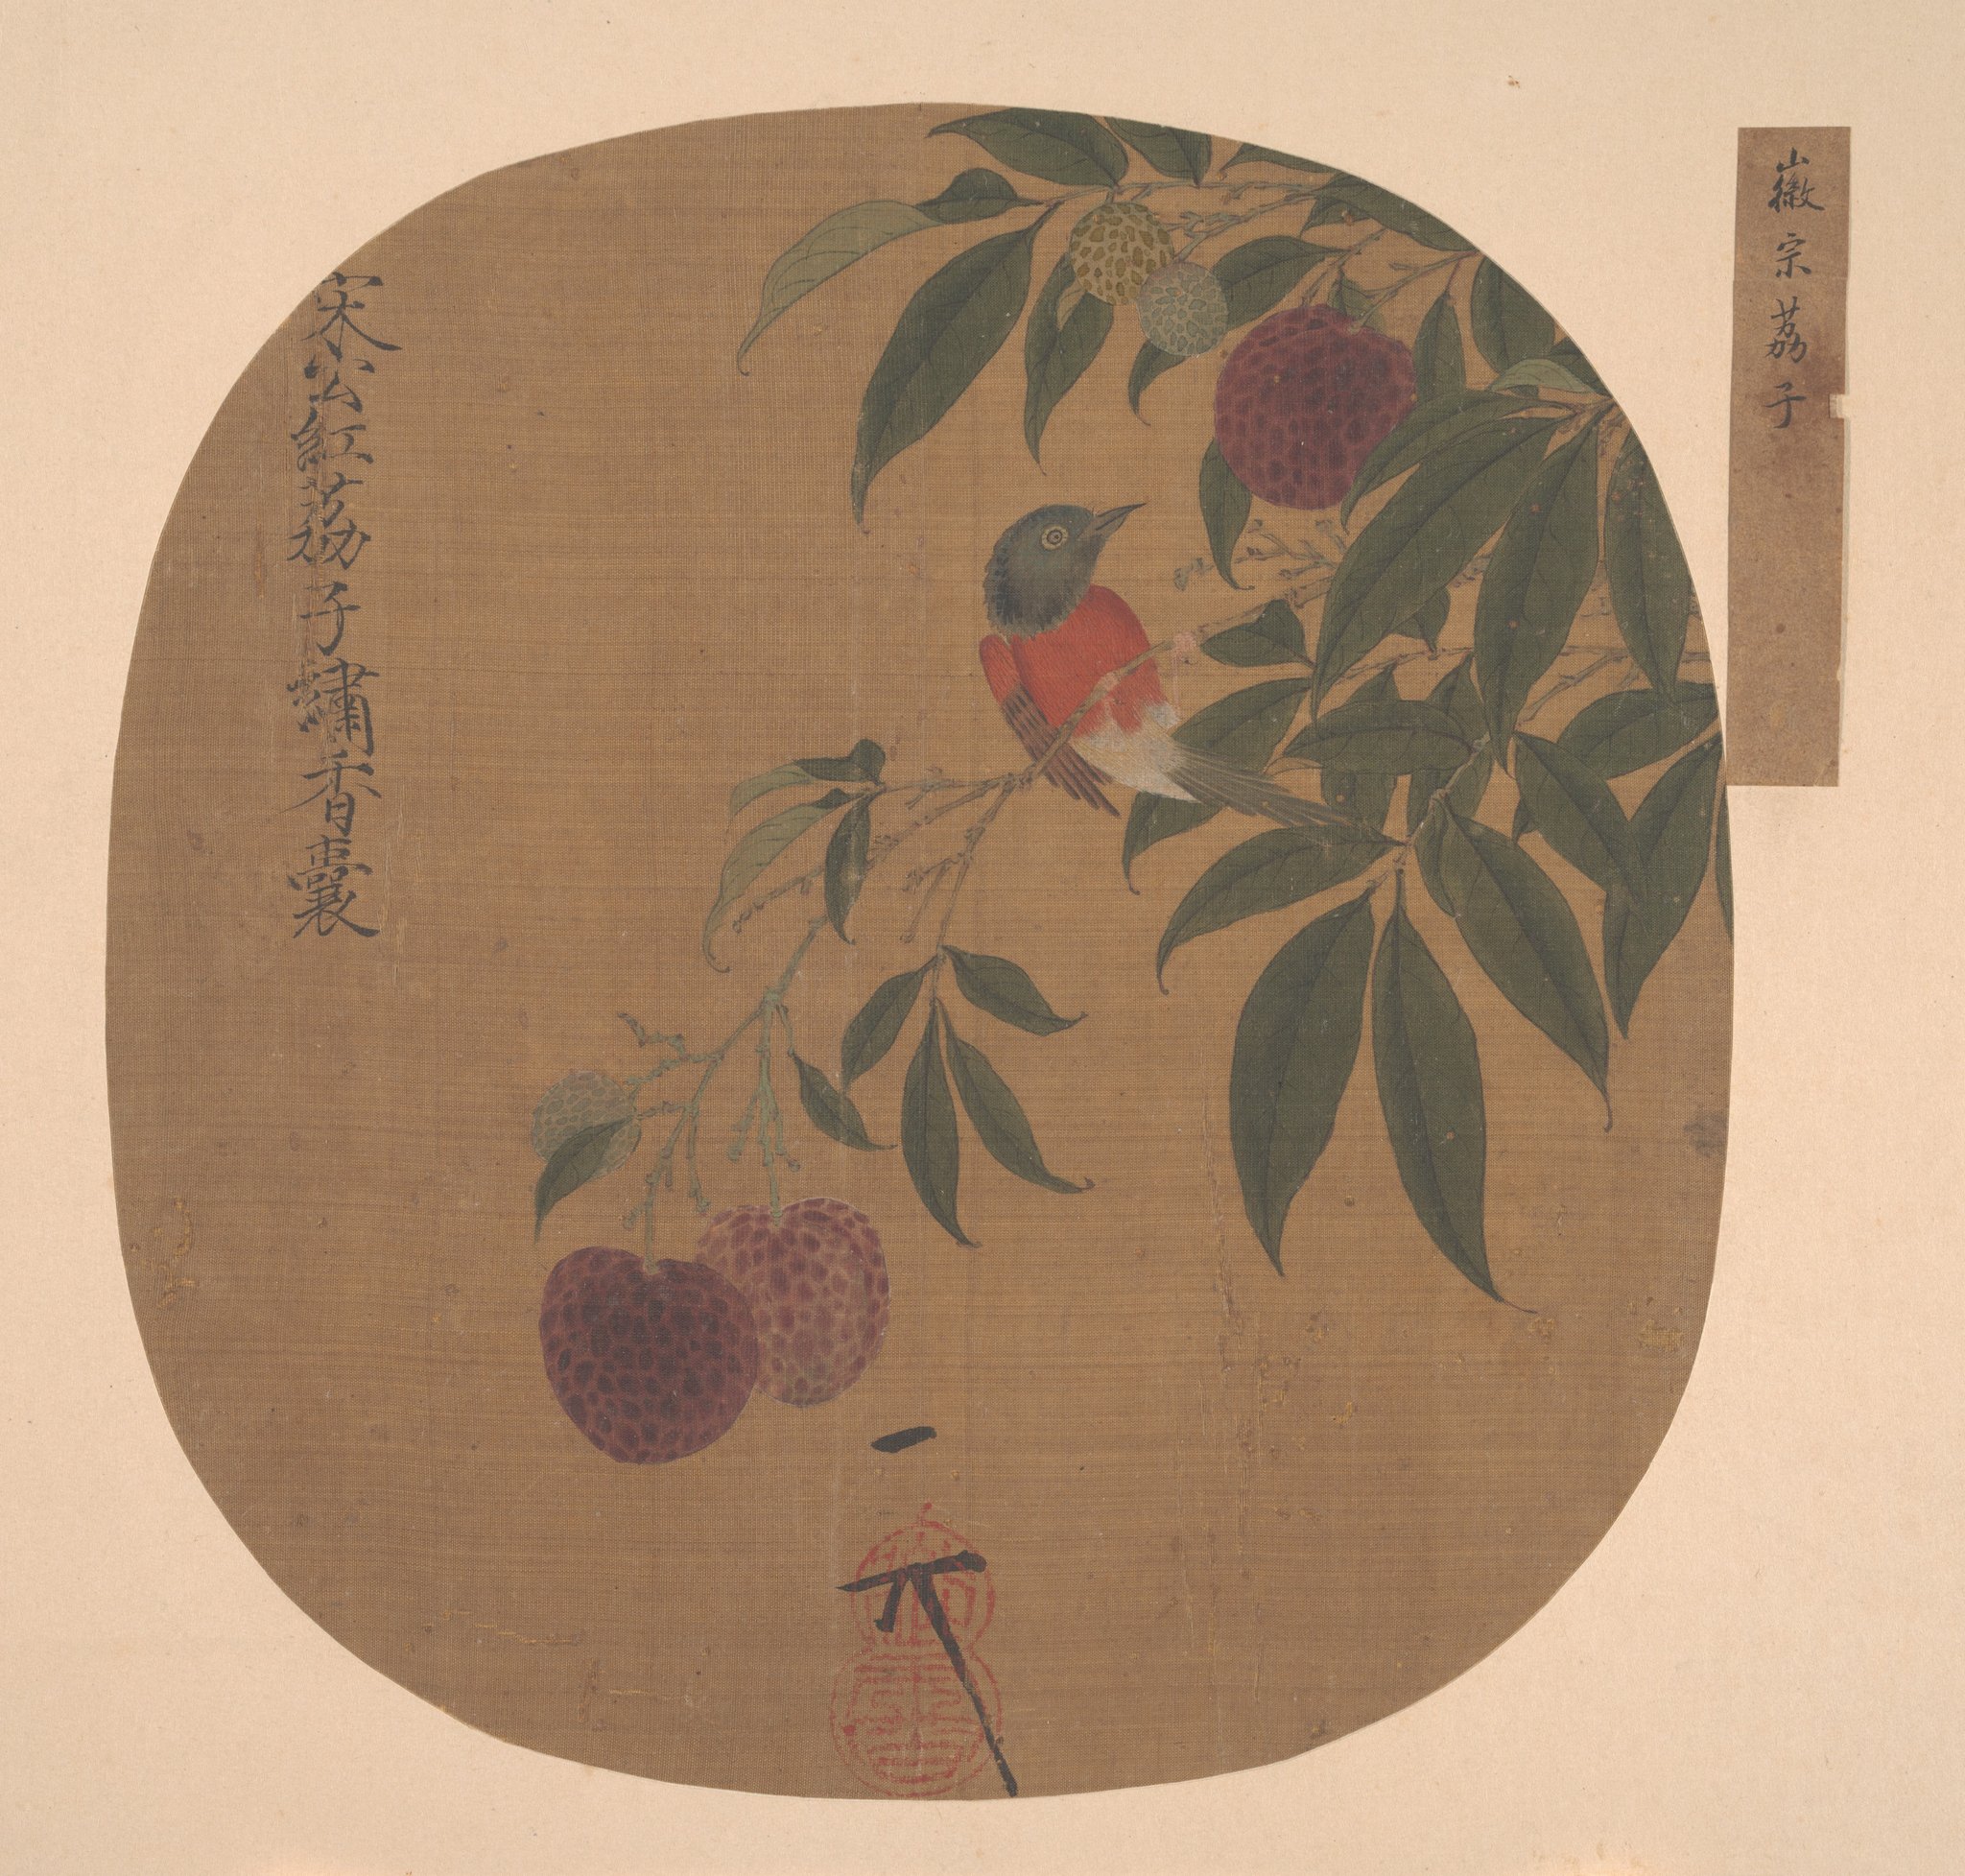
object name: fan mounted a an album leaf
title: Bird on a Lychee Branch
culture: chinese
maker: unidentified artist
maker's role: artist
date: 1368-1644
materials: ink, silk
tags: birds,fruit